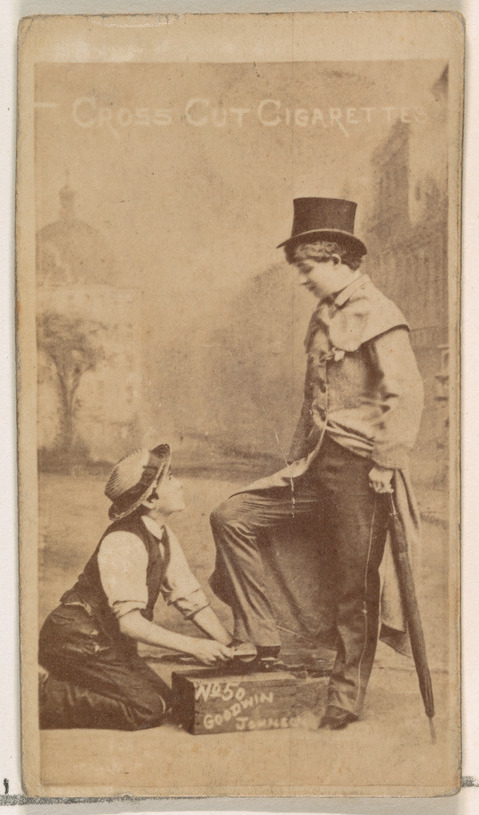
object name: print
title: Card Number 50, Goodwin and Johnson, from the Actors and Actresses series (N145-1) issued by Duke Sons & Co. to promote Cross Cut Cigarettes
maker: w. duke, sons & co.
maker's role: publisher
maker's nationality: american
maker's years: 1870-1920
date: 1880-1889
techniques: albumen silver print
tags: boys,actors